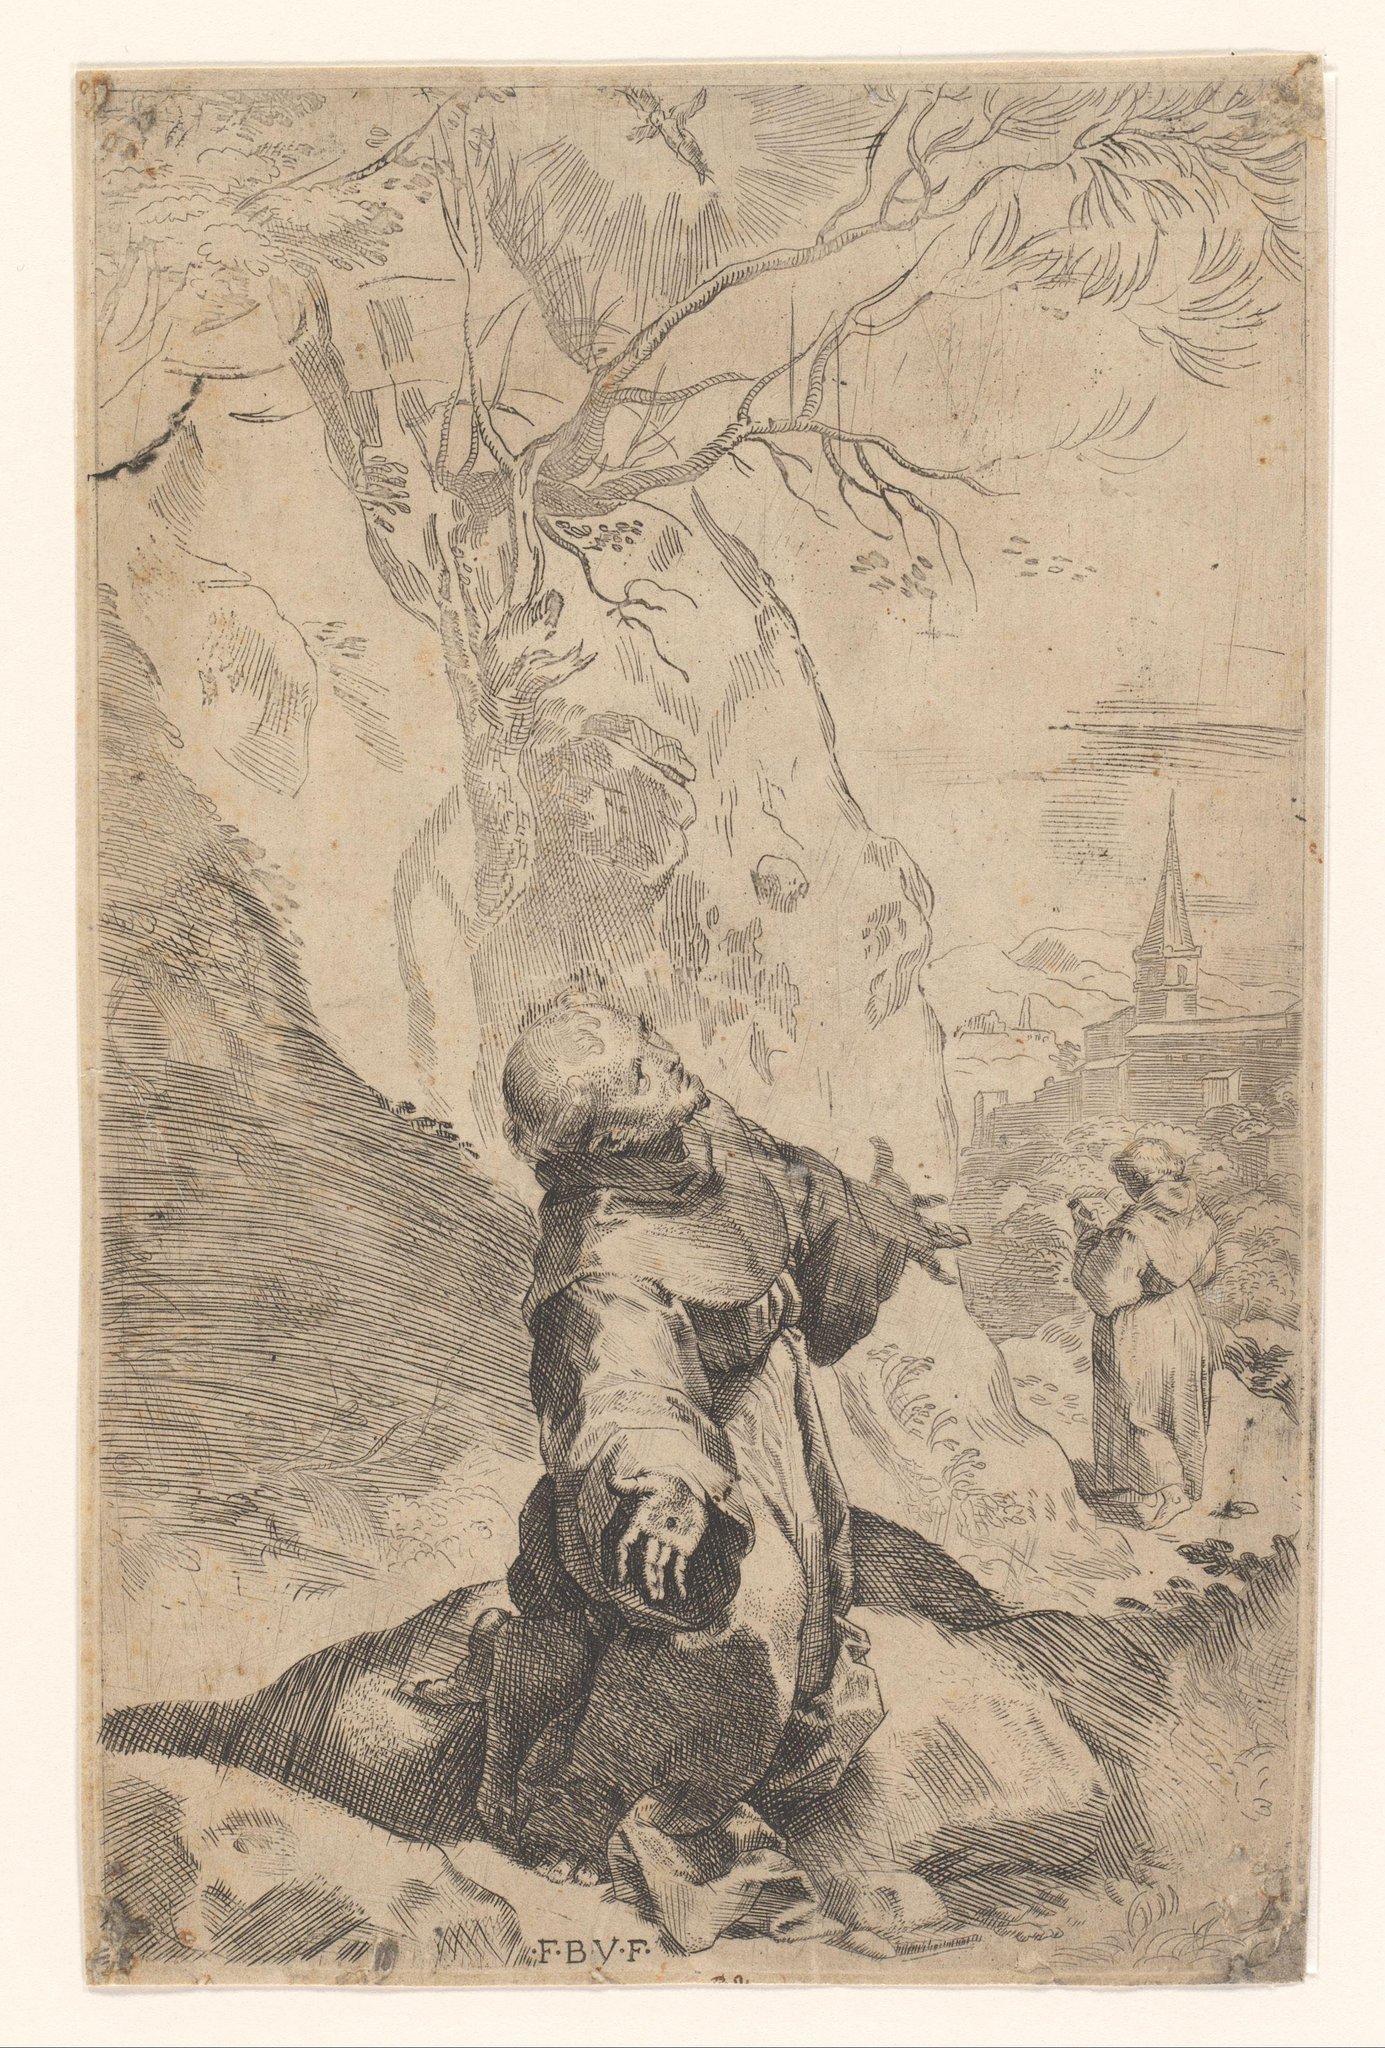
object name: print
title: Stigmatisatie van de heilige Franciscus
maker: federico barocci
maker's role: draughtsman, painter, print maker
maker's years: 1528-1612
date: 1581-1585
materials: paper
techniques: drypoint, engraving, etching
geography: urbino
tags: stigmatization of st. francis of assisi: in retreat on mount alverna, he beholds a vision of christ on the cross enveloped by wings (like a seraph with six wings); rays passing down to the body of the kneeling saint form the marks of the five wounds of christ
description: De heilige Franciscus geknield bij een boom, de armen gespreid, de blik gericht op een crucifix boven hem aan de hemel. Op de achtergrond een broeder op de rug gezien, al lezend terwijl hij in de richting van een kerk wandelt.